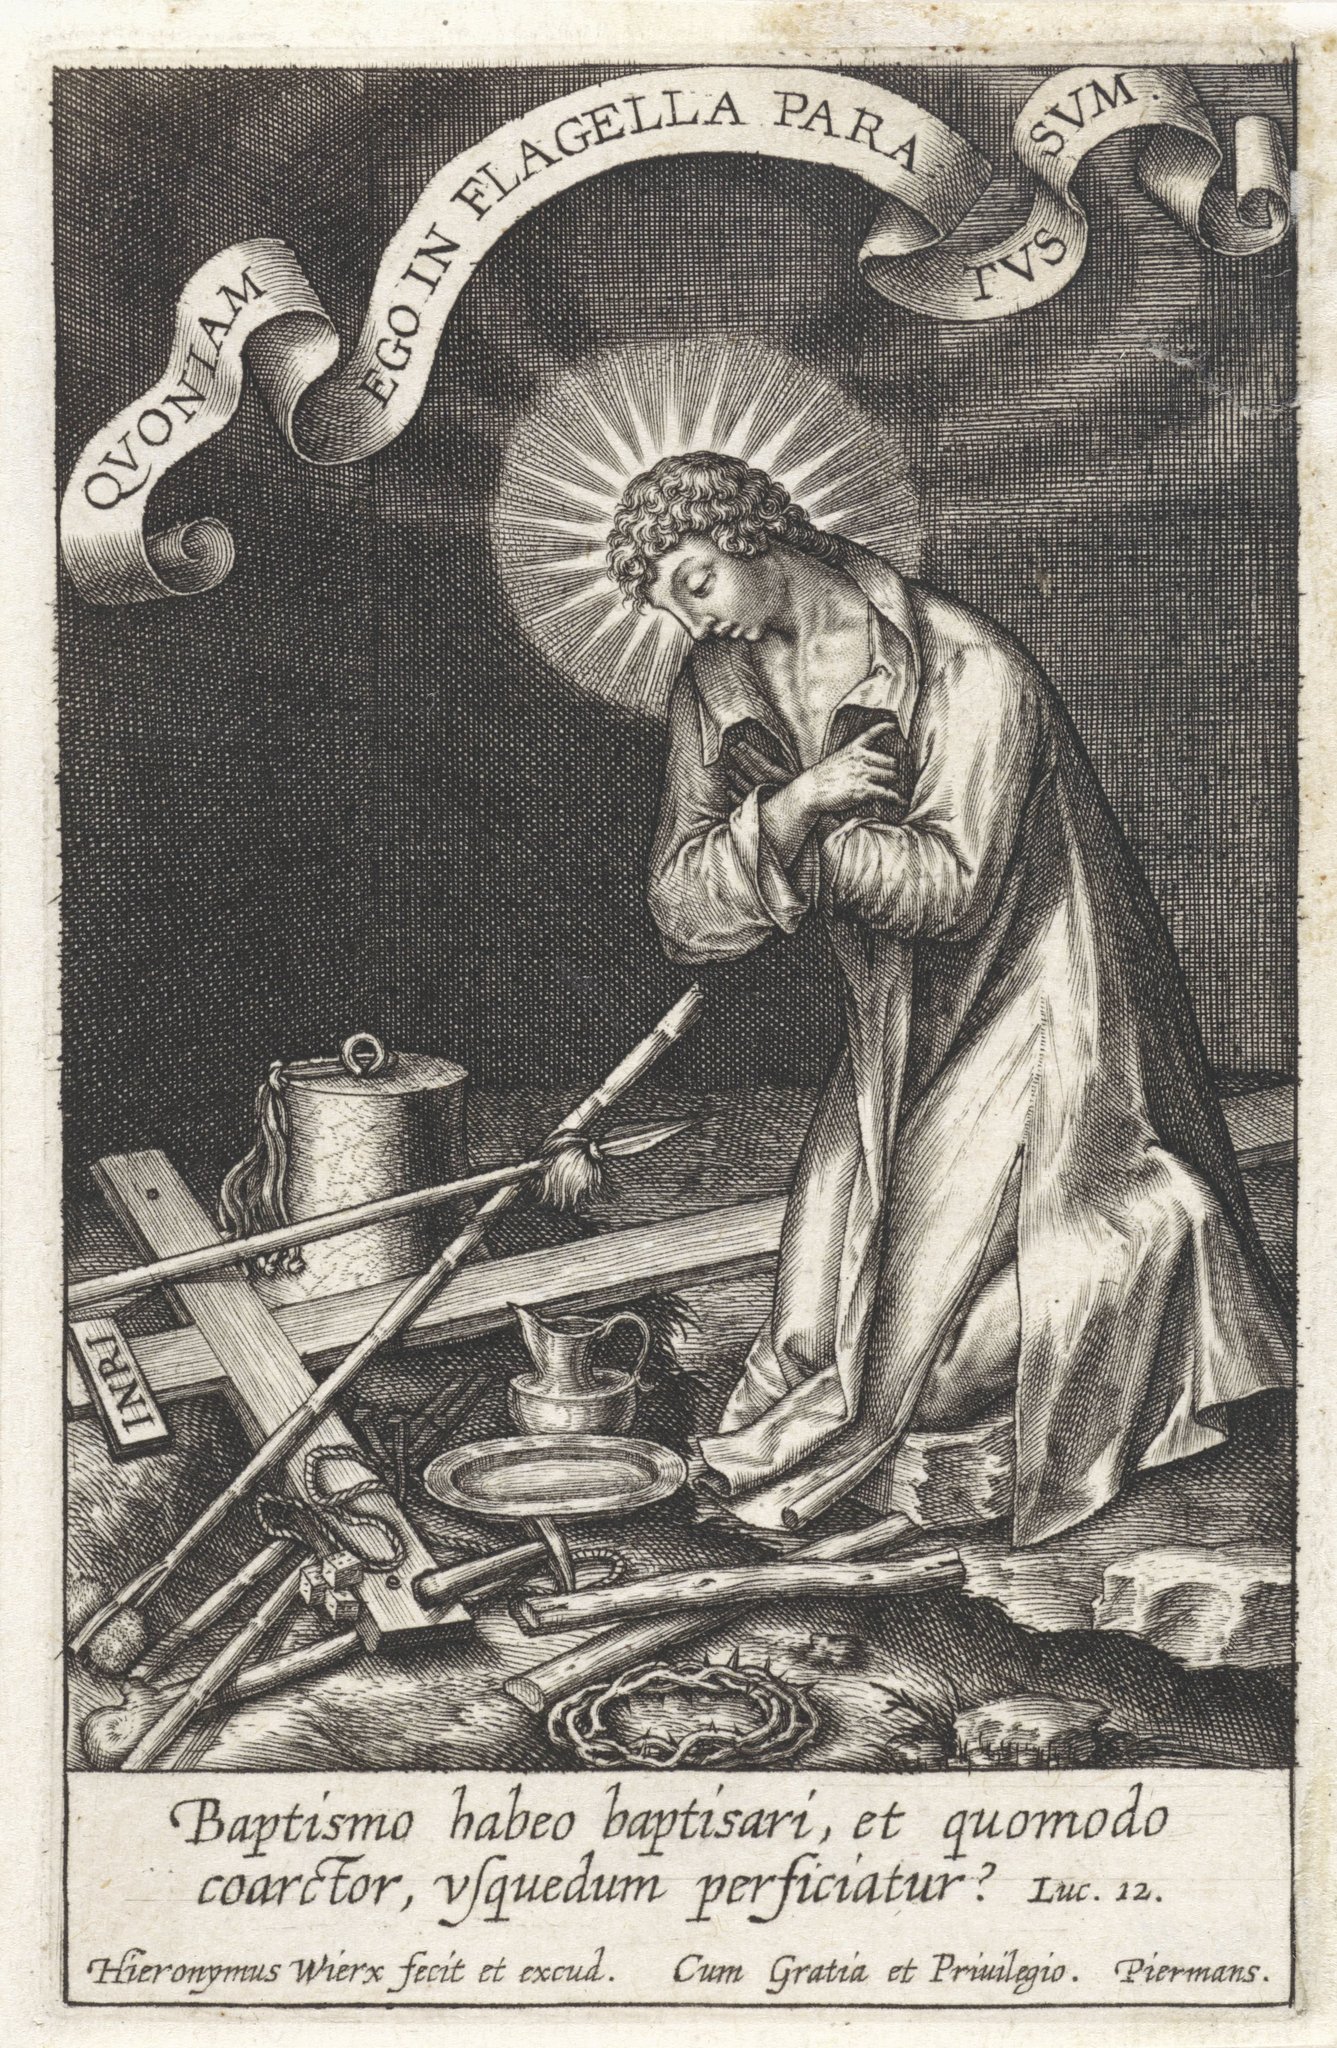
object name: print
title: Onbekende mannelijke heilige, peinzend bij de passiewerktuigen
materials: paper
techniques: engraving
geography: antwerp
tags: single instruments of the passion, saints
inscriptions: collector's mark: Lugt 2542, collector's mark: Lugt 2228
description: Een mannelijke heilige, zijn hoofd omgeven door een aureool, knielend met zijn handen voor zijn borst gevouwen. Hij kijkt peinzend naar de passiewerktuigen die op de grond voor hem liggen. In de lucht een banderol met een opschrift in het Latijn. In de marge een tweeregelig Bijbelcitaat uit Luc. 12 in het Latijn.